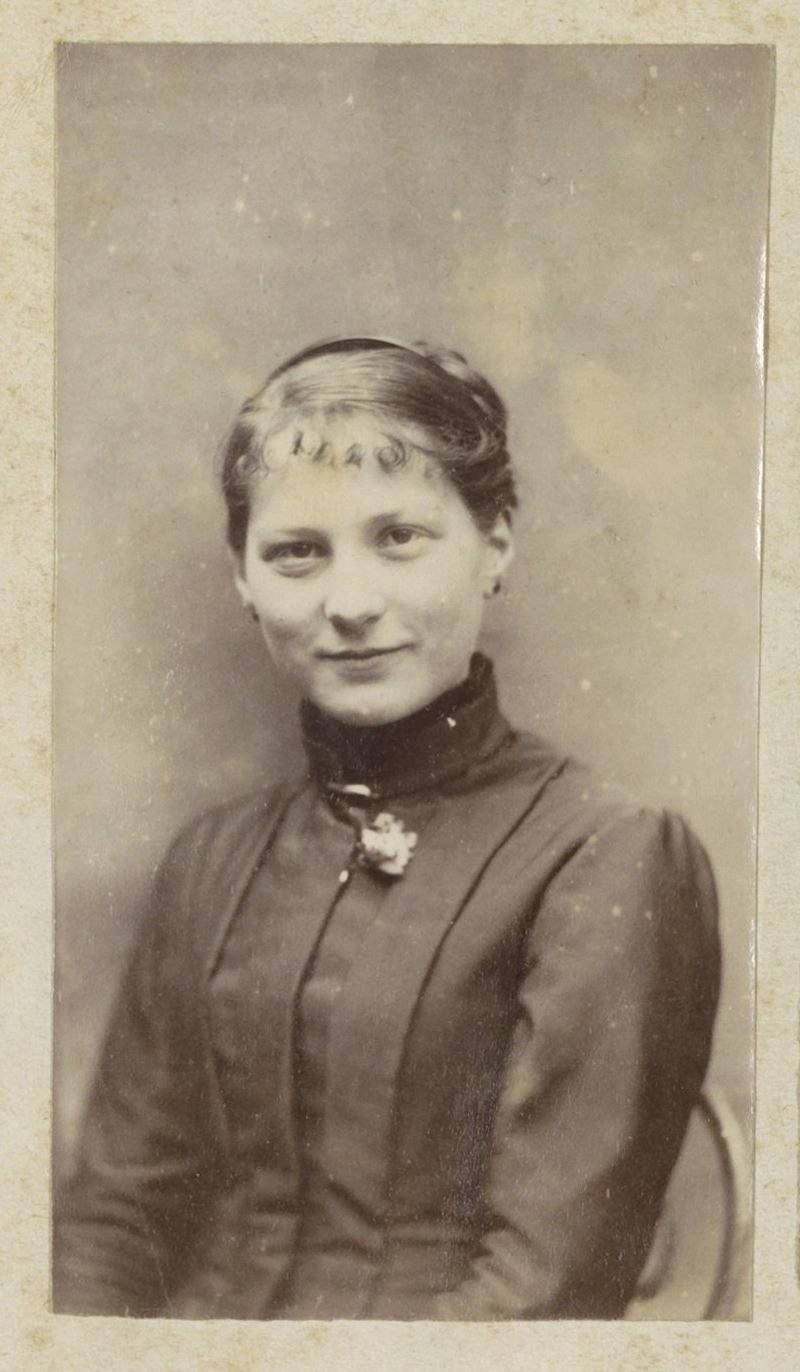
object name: photograph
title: Portret van een onbekende Française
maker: Anonymous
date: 1883-1886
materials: photographic support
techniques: albumen print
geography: france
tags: adult woman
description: Onderdeel van Album van een Franse amateurfotograaf met opnames van familie, militairen, industrie, landschappen en bezienswaardigheden in Frankrijk.